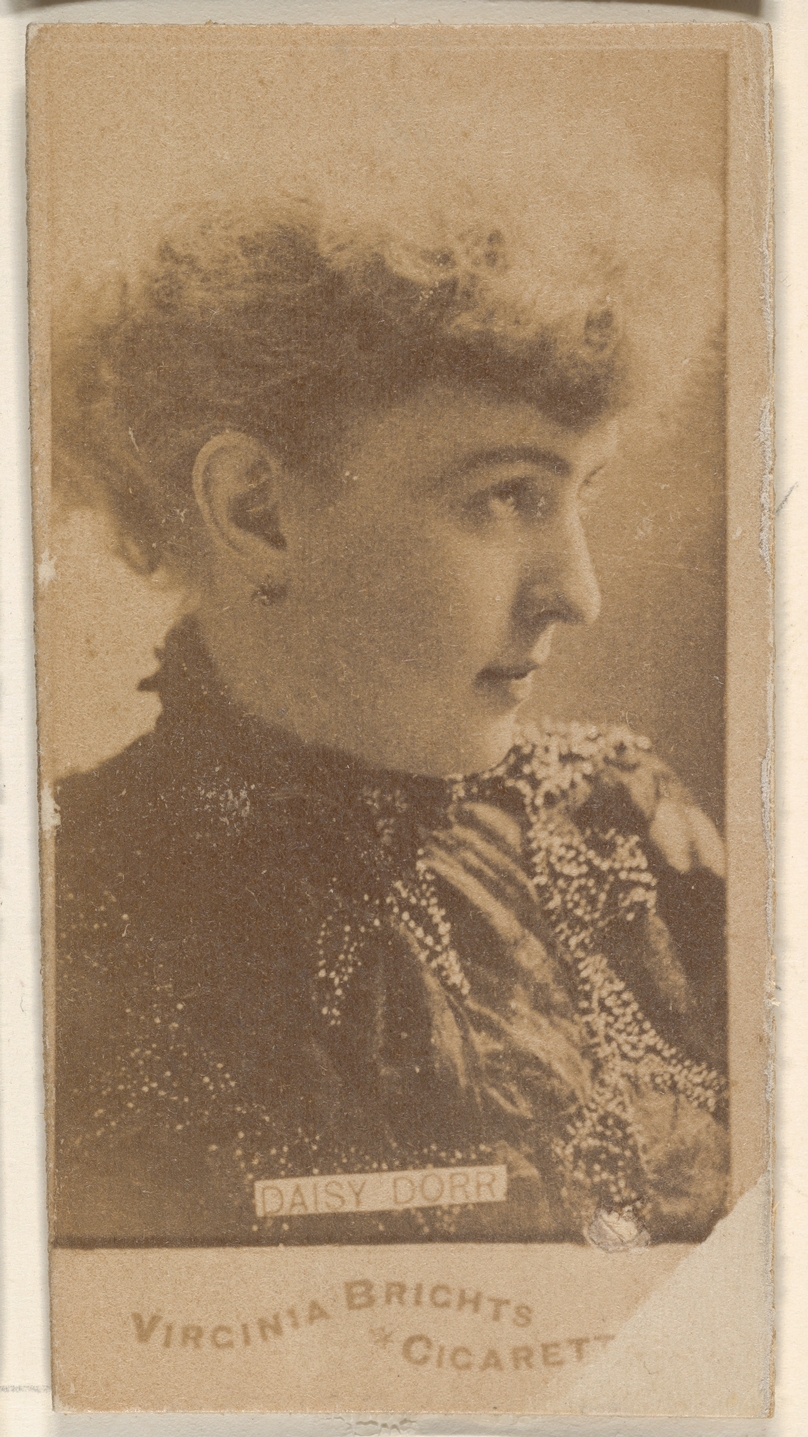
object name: photograph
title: Daisy Dorr, from the Actors and Actresses series (N45, Type 1) for Virginia Brights Cigarettes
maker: allen & ginter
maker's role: publisher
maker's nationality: american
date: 1888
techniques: albumen silver print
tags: portraits,women,actresses